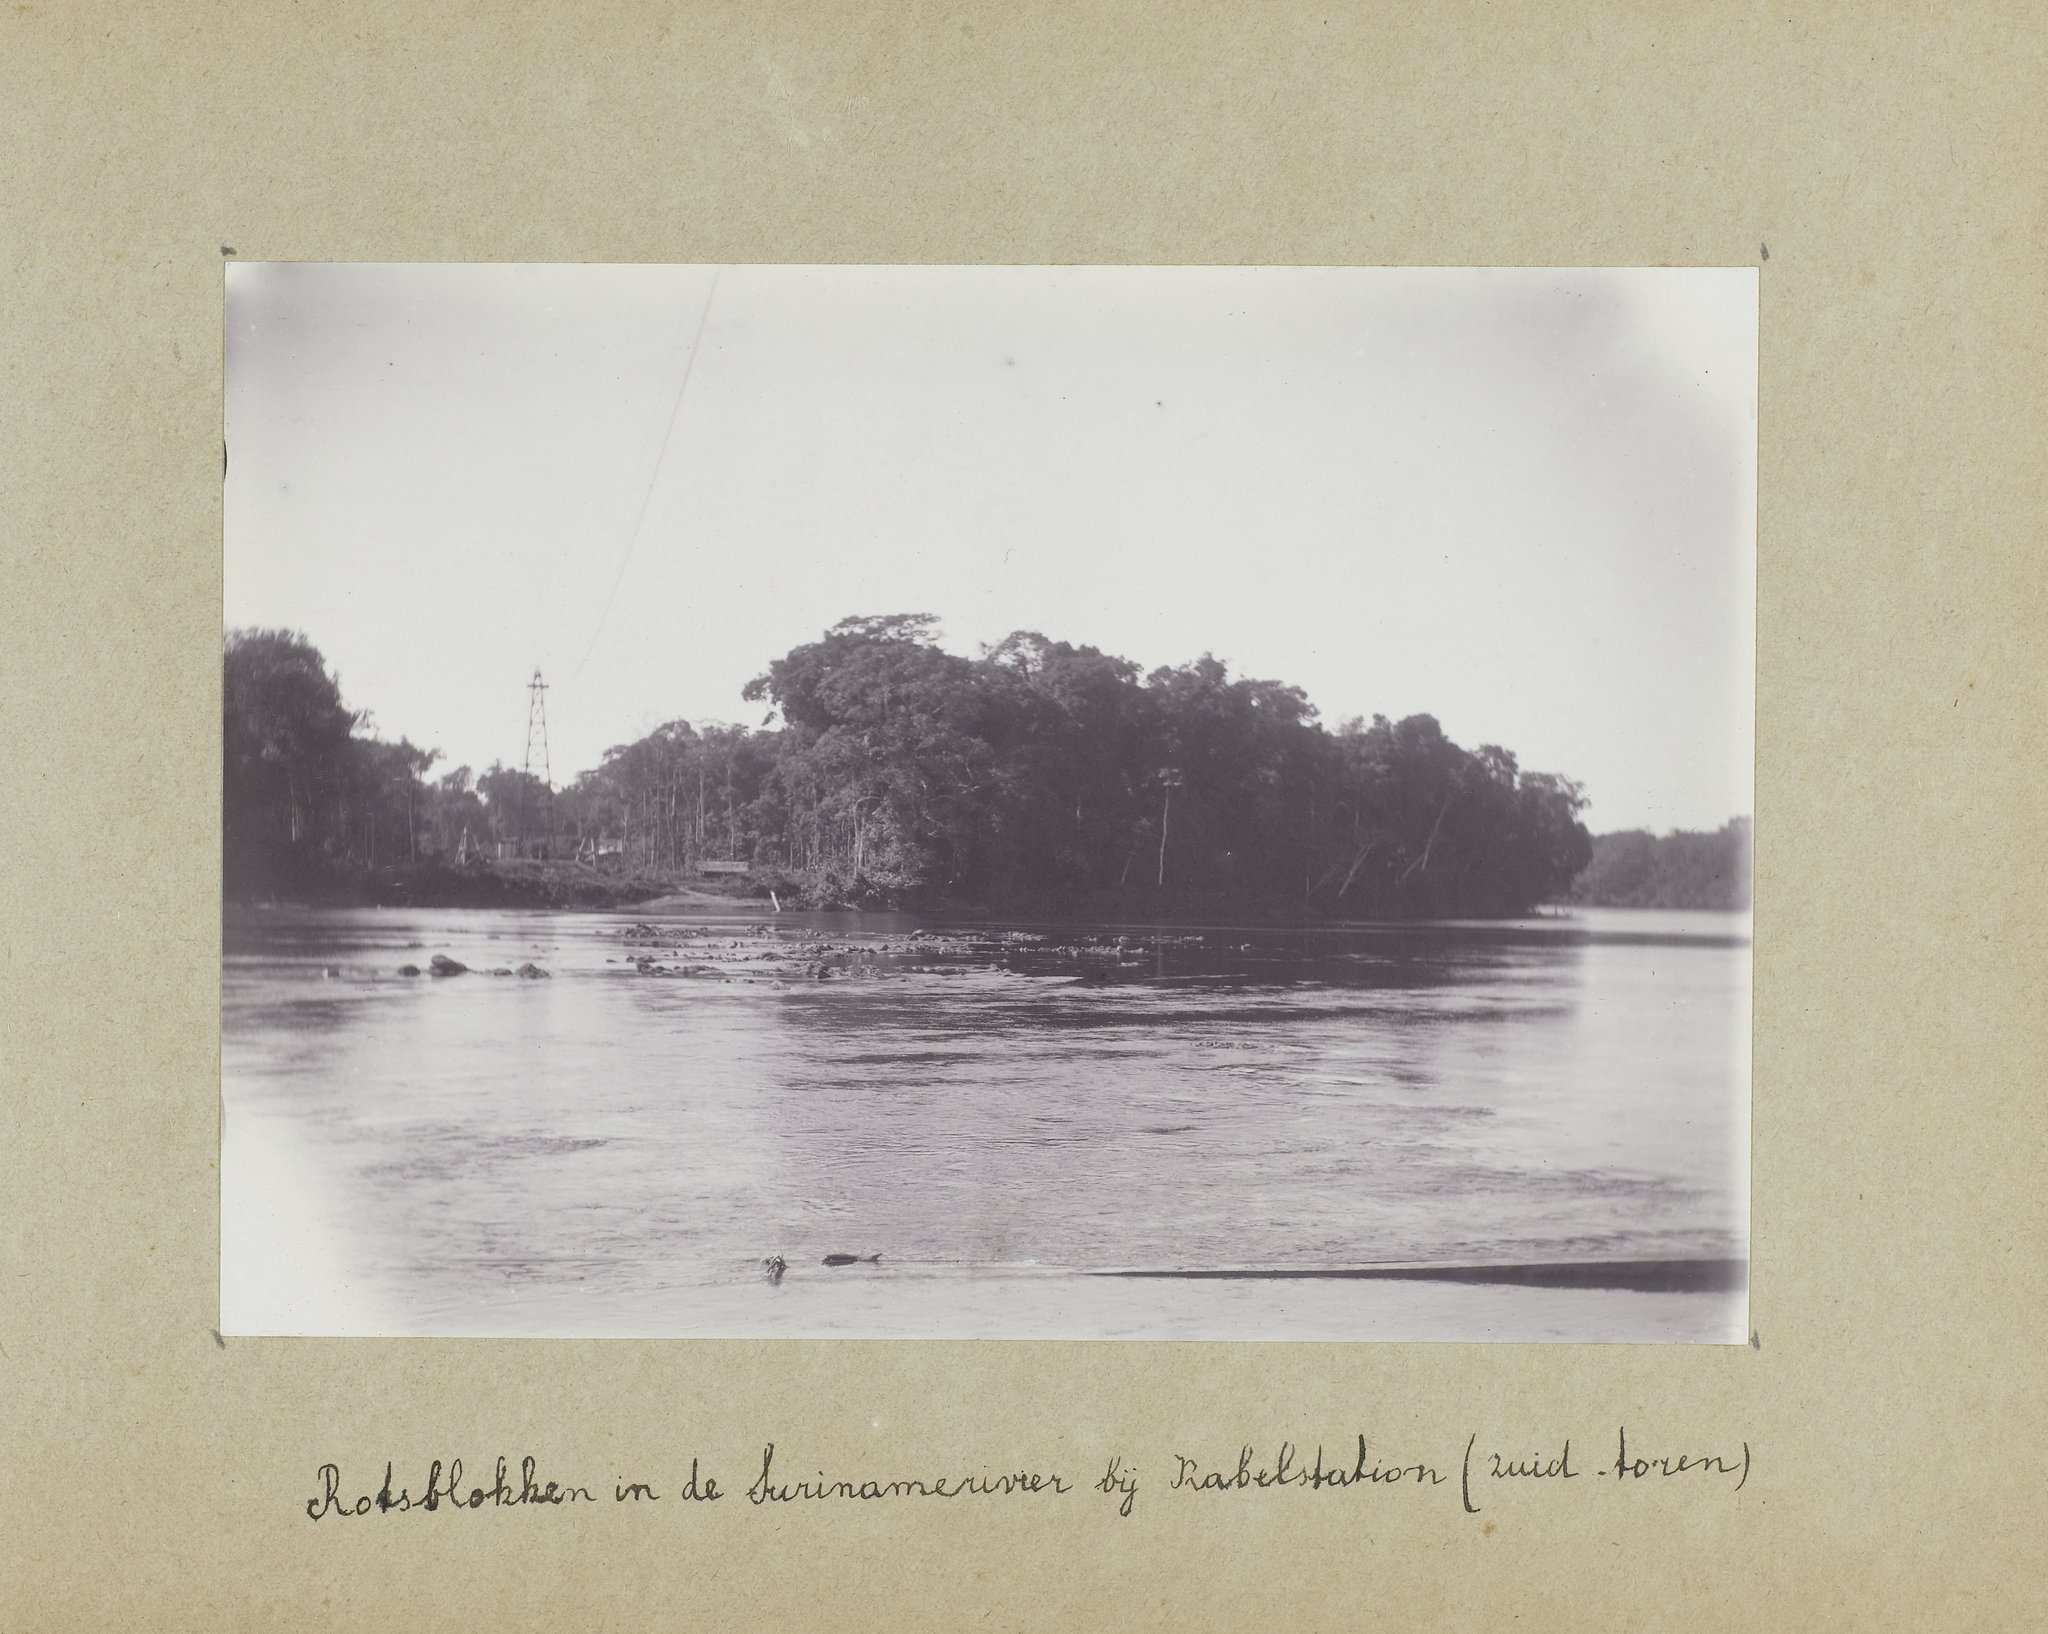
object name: photograph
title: Rotsblokken in de Surinamerivier bij Kabelstation (zuid-toren)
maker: Anonymous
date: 1905-1910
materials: photographic support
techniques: photography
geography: suriname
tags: jacob evert wesenhagen, railway, tramway; rack railway, suriname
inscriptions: inscription: ‘Rotsblokken in de Surinamerivier bij Kabelstation (zuid-toren)’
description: Rotsen in de Surinamerivier onder de kabelbrug, in de verte de toren aan de zuidzijde. Foto in het fotoalbum over de aanleg van de Lawaspoorweg in Suriname in de jaren 1903-1912. Onderdeel van een groep objecten afkomstig van de familie Wesenhagen in Suriname.